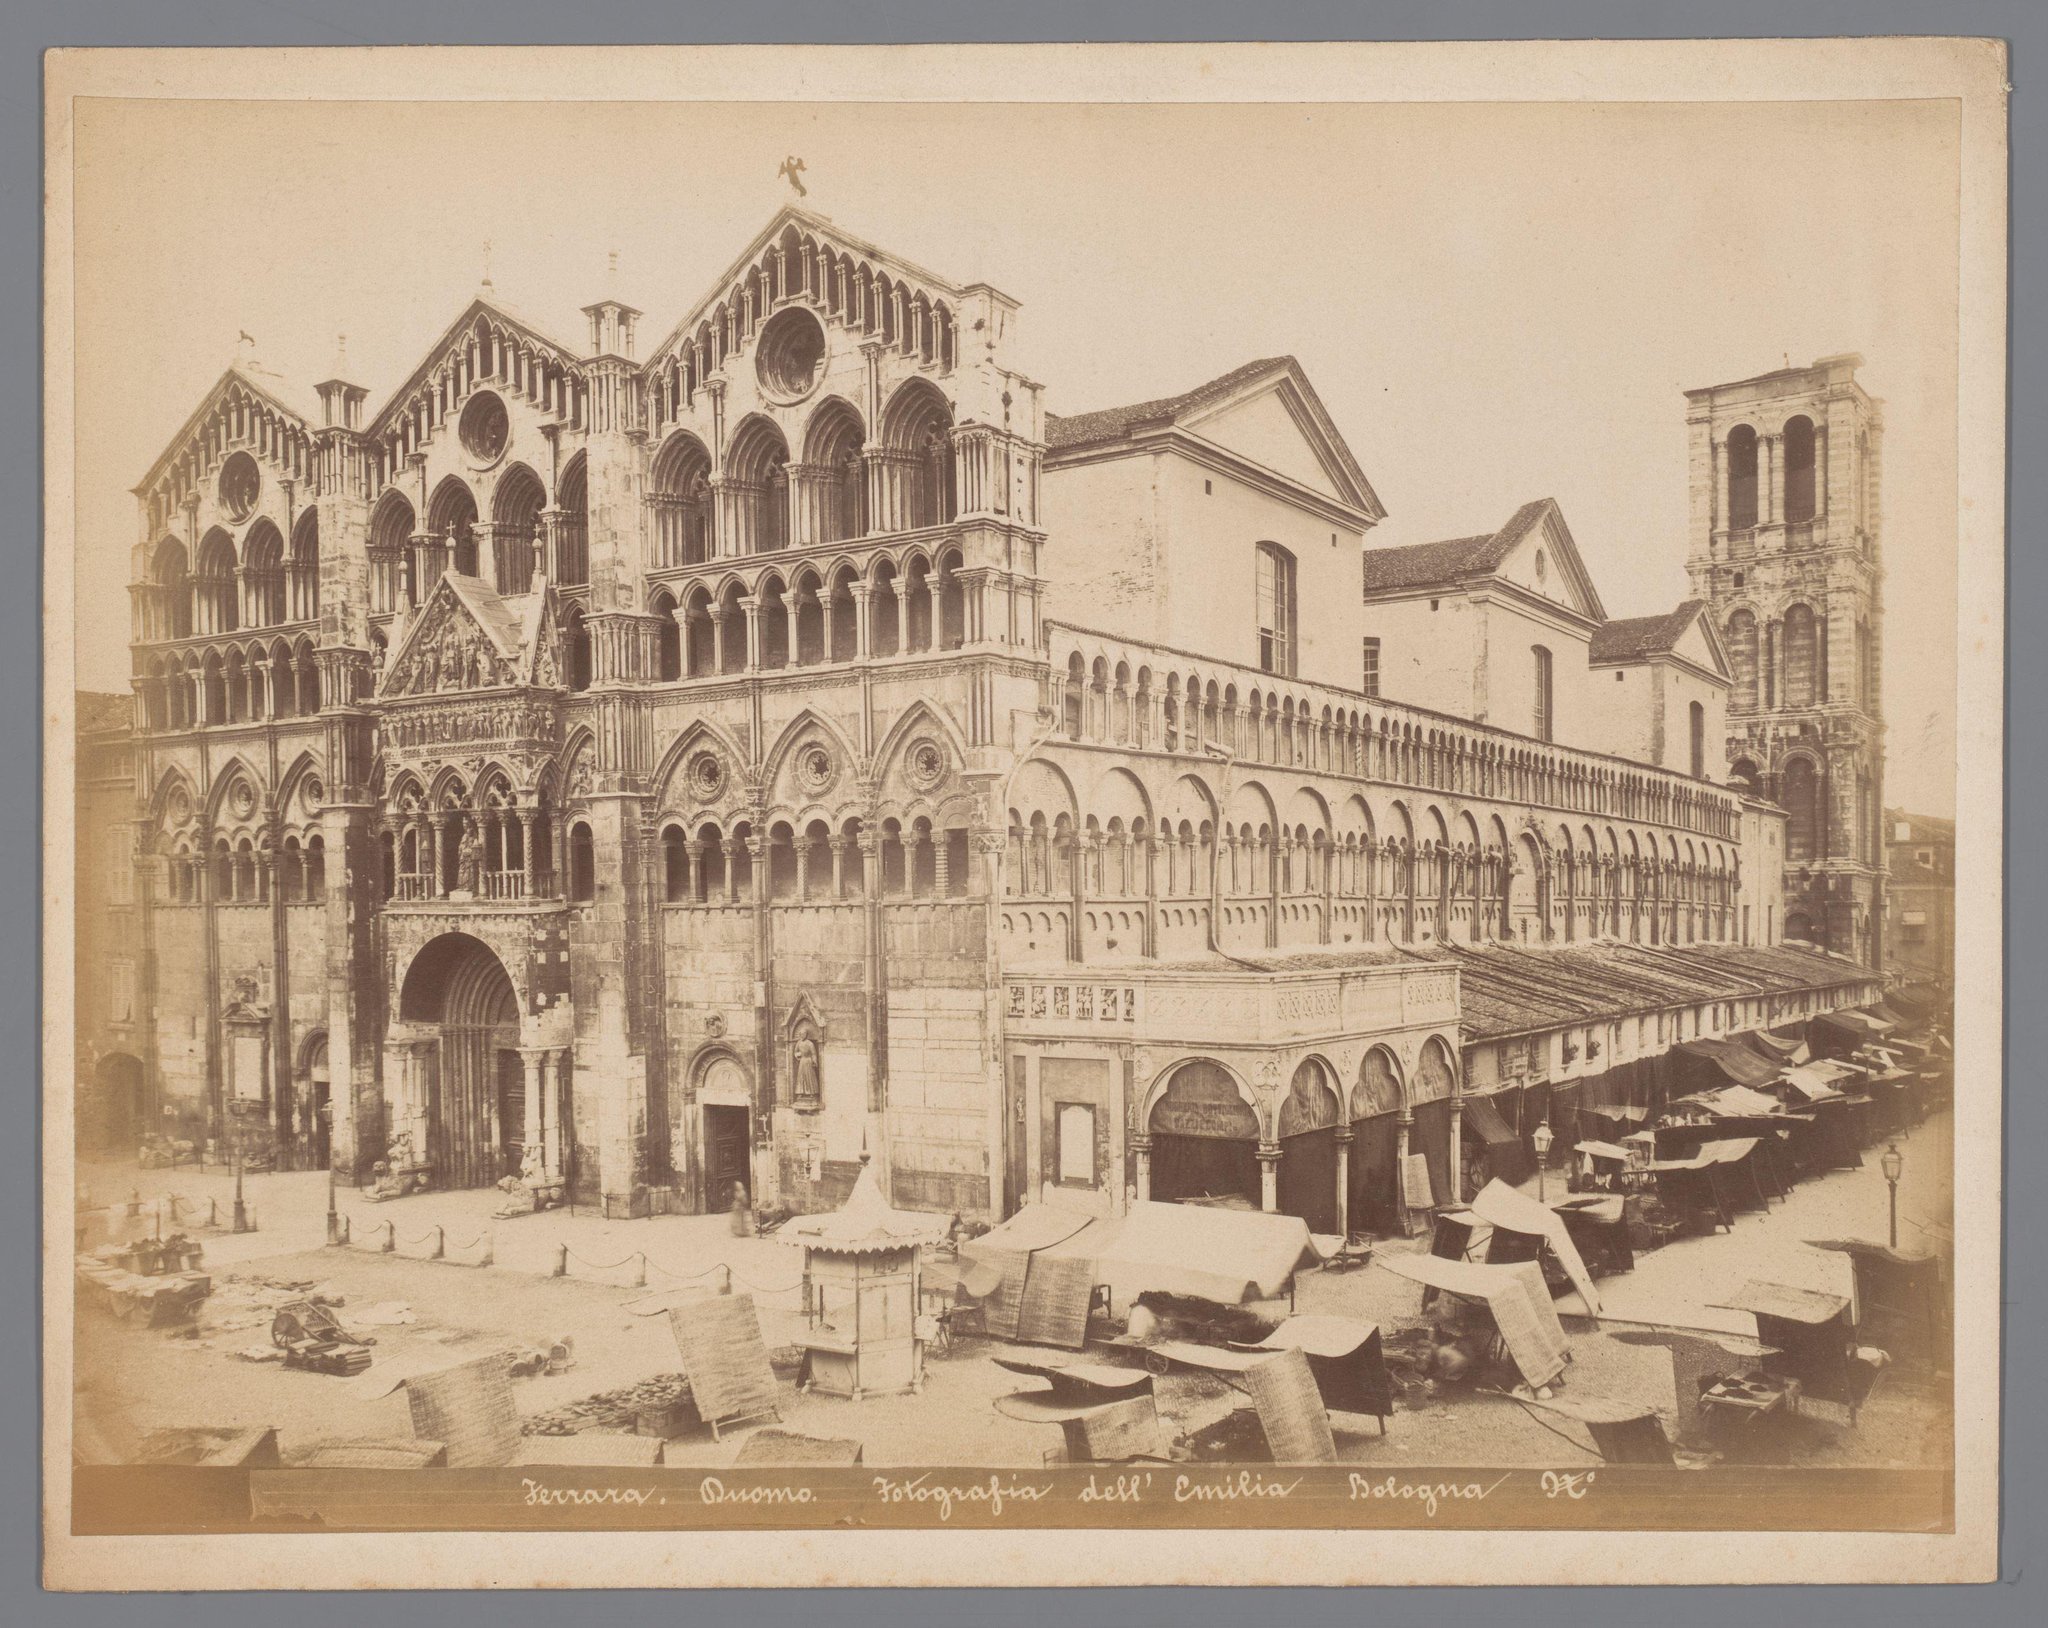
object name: photograph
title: Ferrara, Duomo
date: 1865-1907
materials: cardboard, paper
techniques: albumen print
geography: ferrara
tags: church (exterior), market